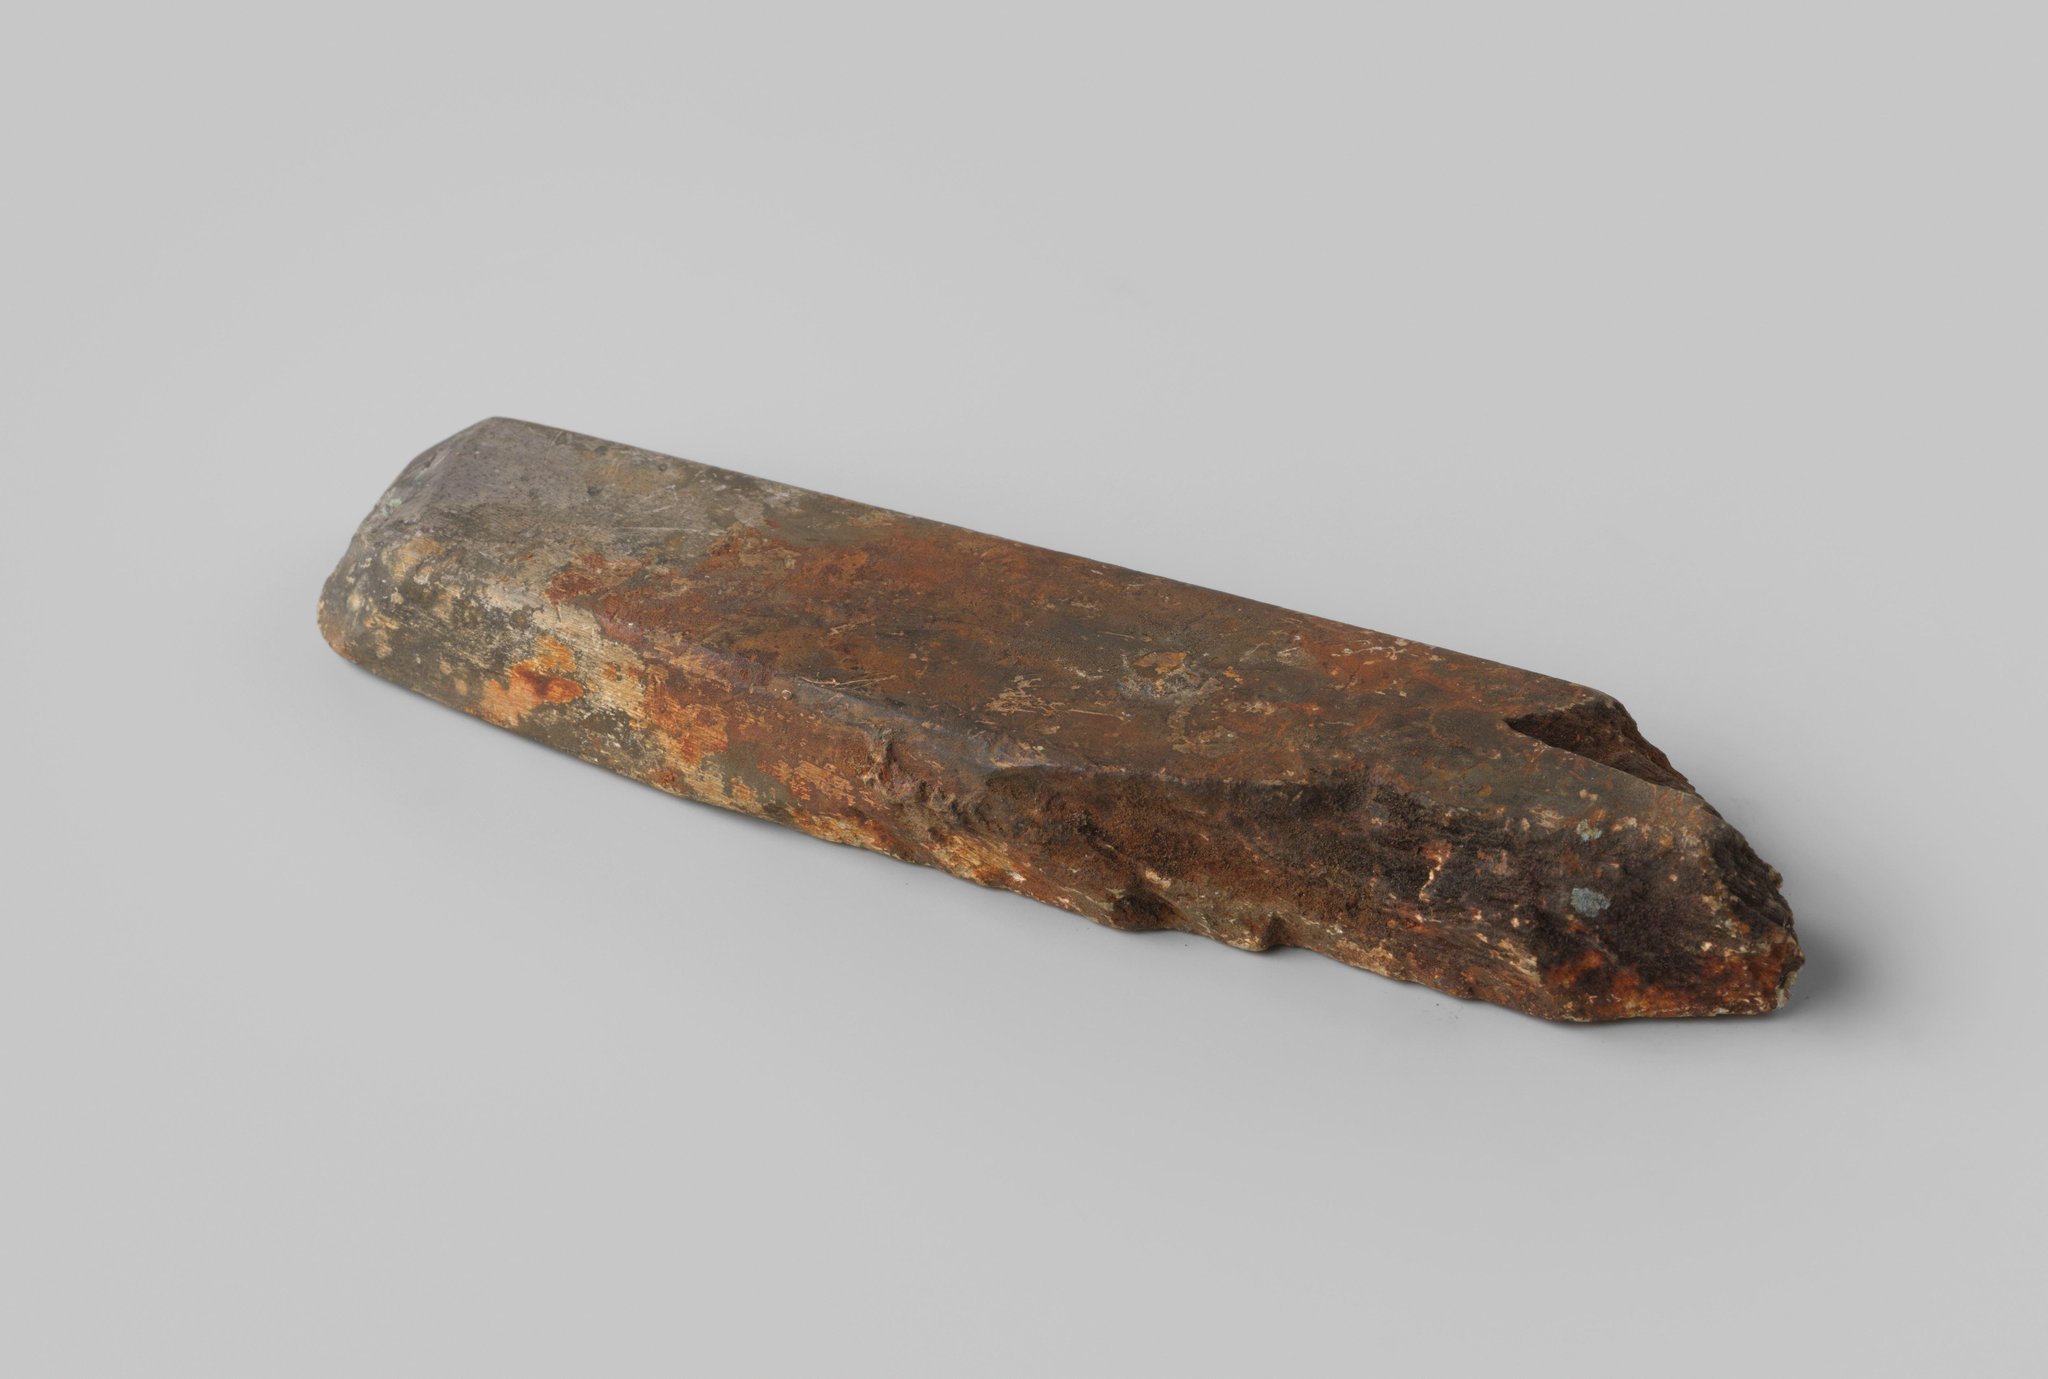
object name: whetstone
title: Slijpsteen uit het wrak van de Oost-Indiëvaarder Hollandia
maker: Anonymous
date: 1700-1743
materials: stone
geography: netherlands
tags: verenigde oostindische compagnie, hollandia (schip), annet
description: Hone; fragm, one end broken: tapering rounded end, flat underside, oblique rounded sides.